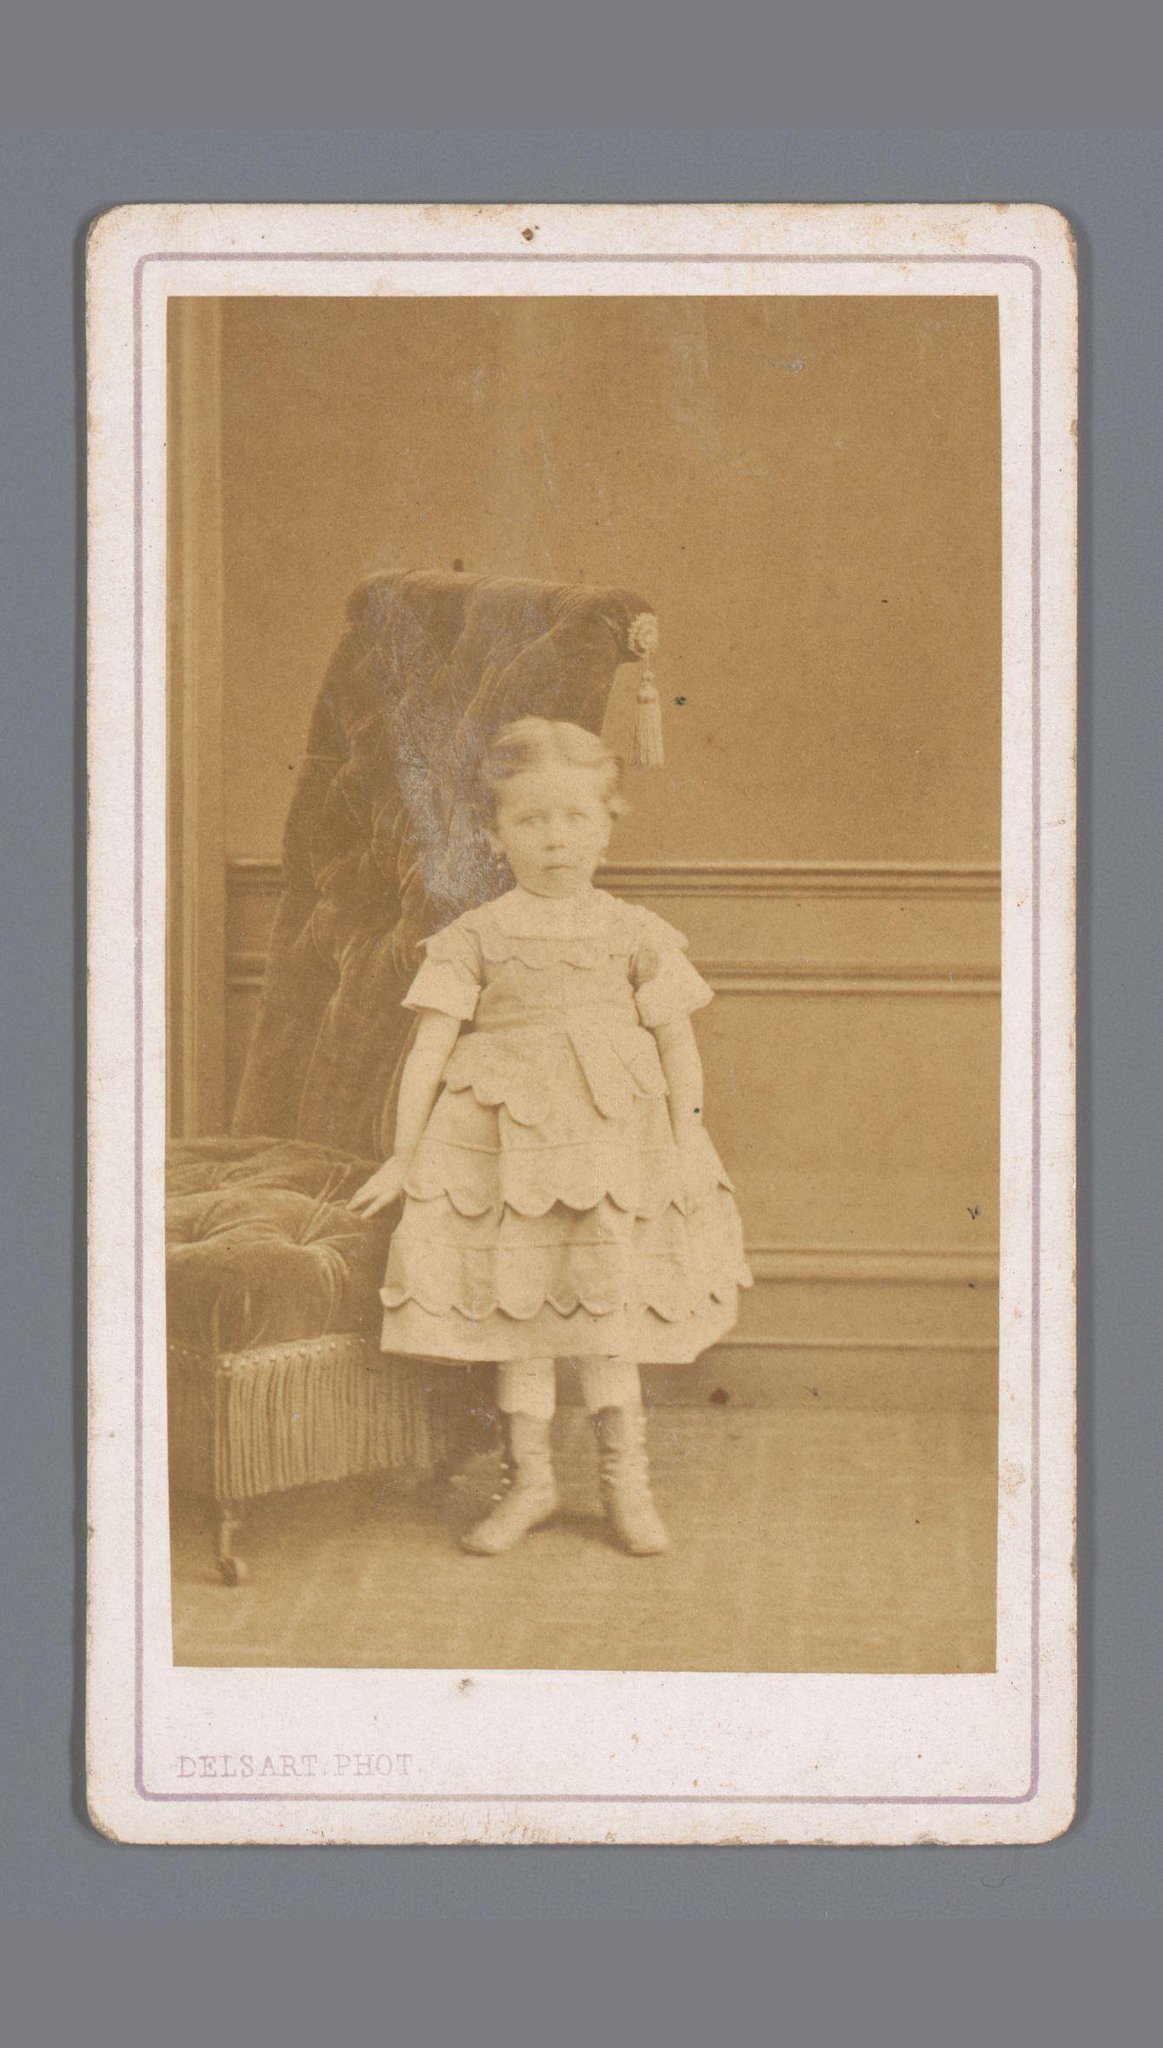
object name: carte de visite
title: Portret van een onbekende meisje bij een fauteuil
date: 1863-1885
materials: cardboard, paper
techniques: albumen print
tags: girl (child between toddler and youth), anonymous historical person portrayed